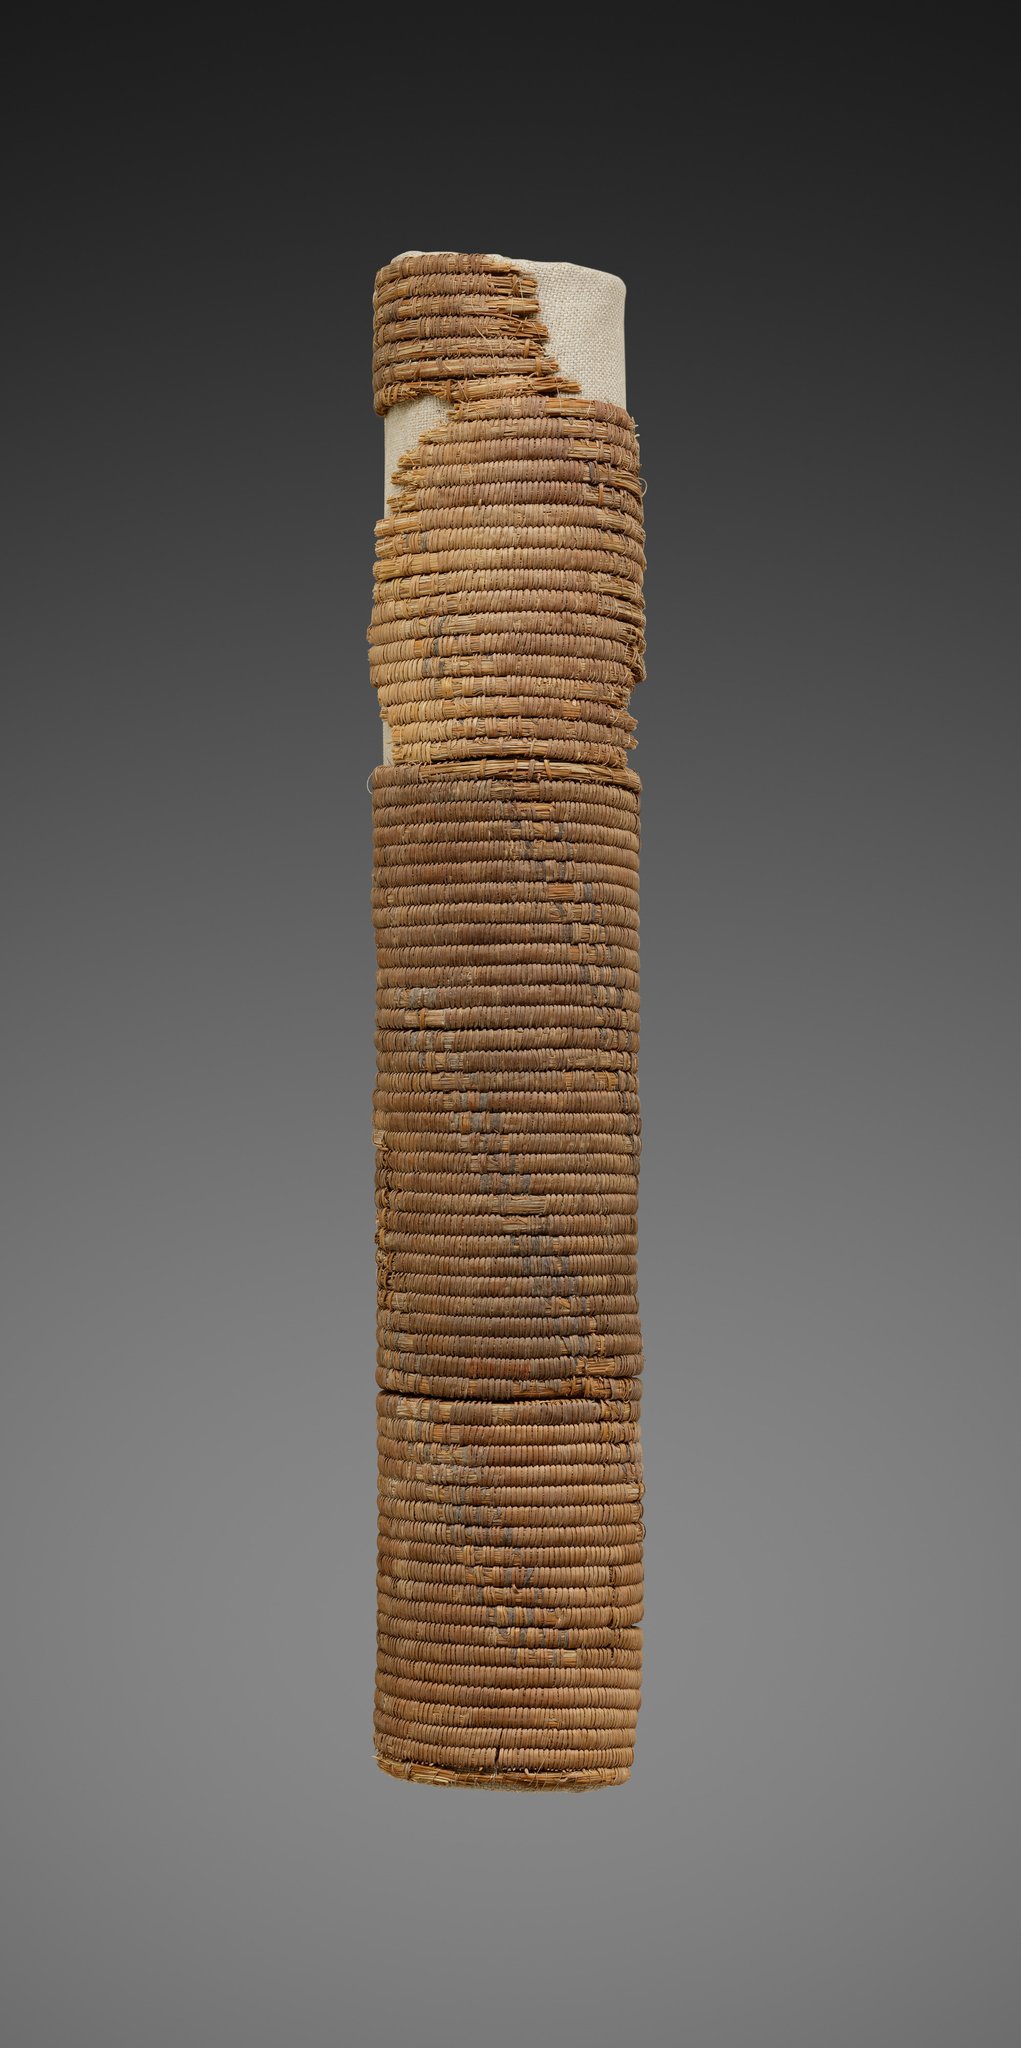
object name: quiver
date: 1981-1550 BCE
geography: egypt